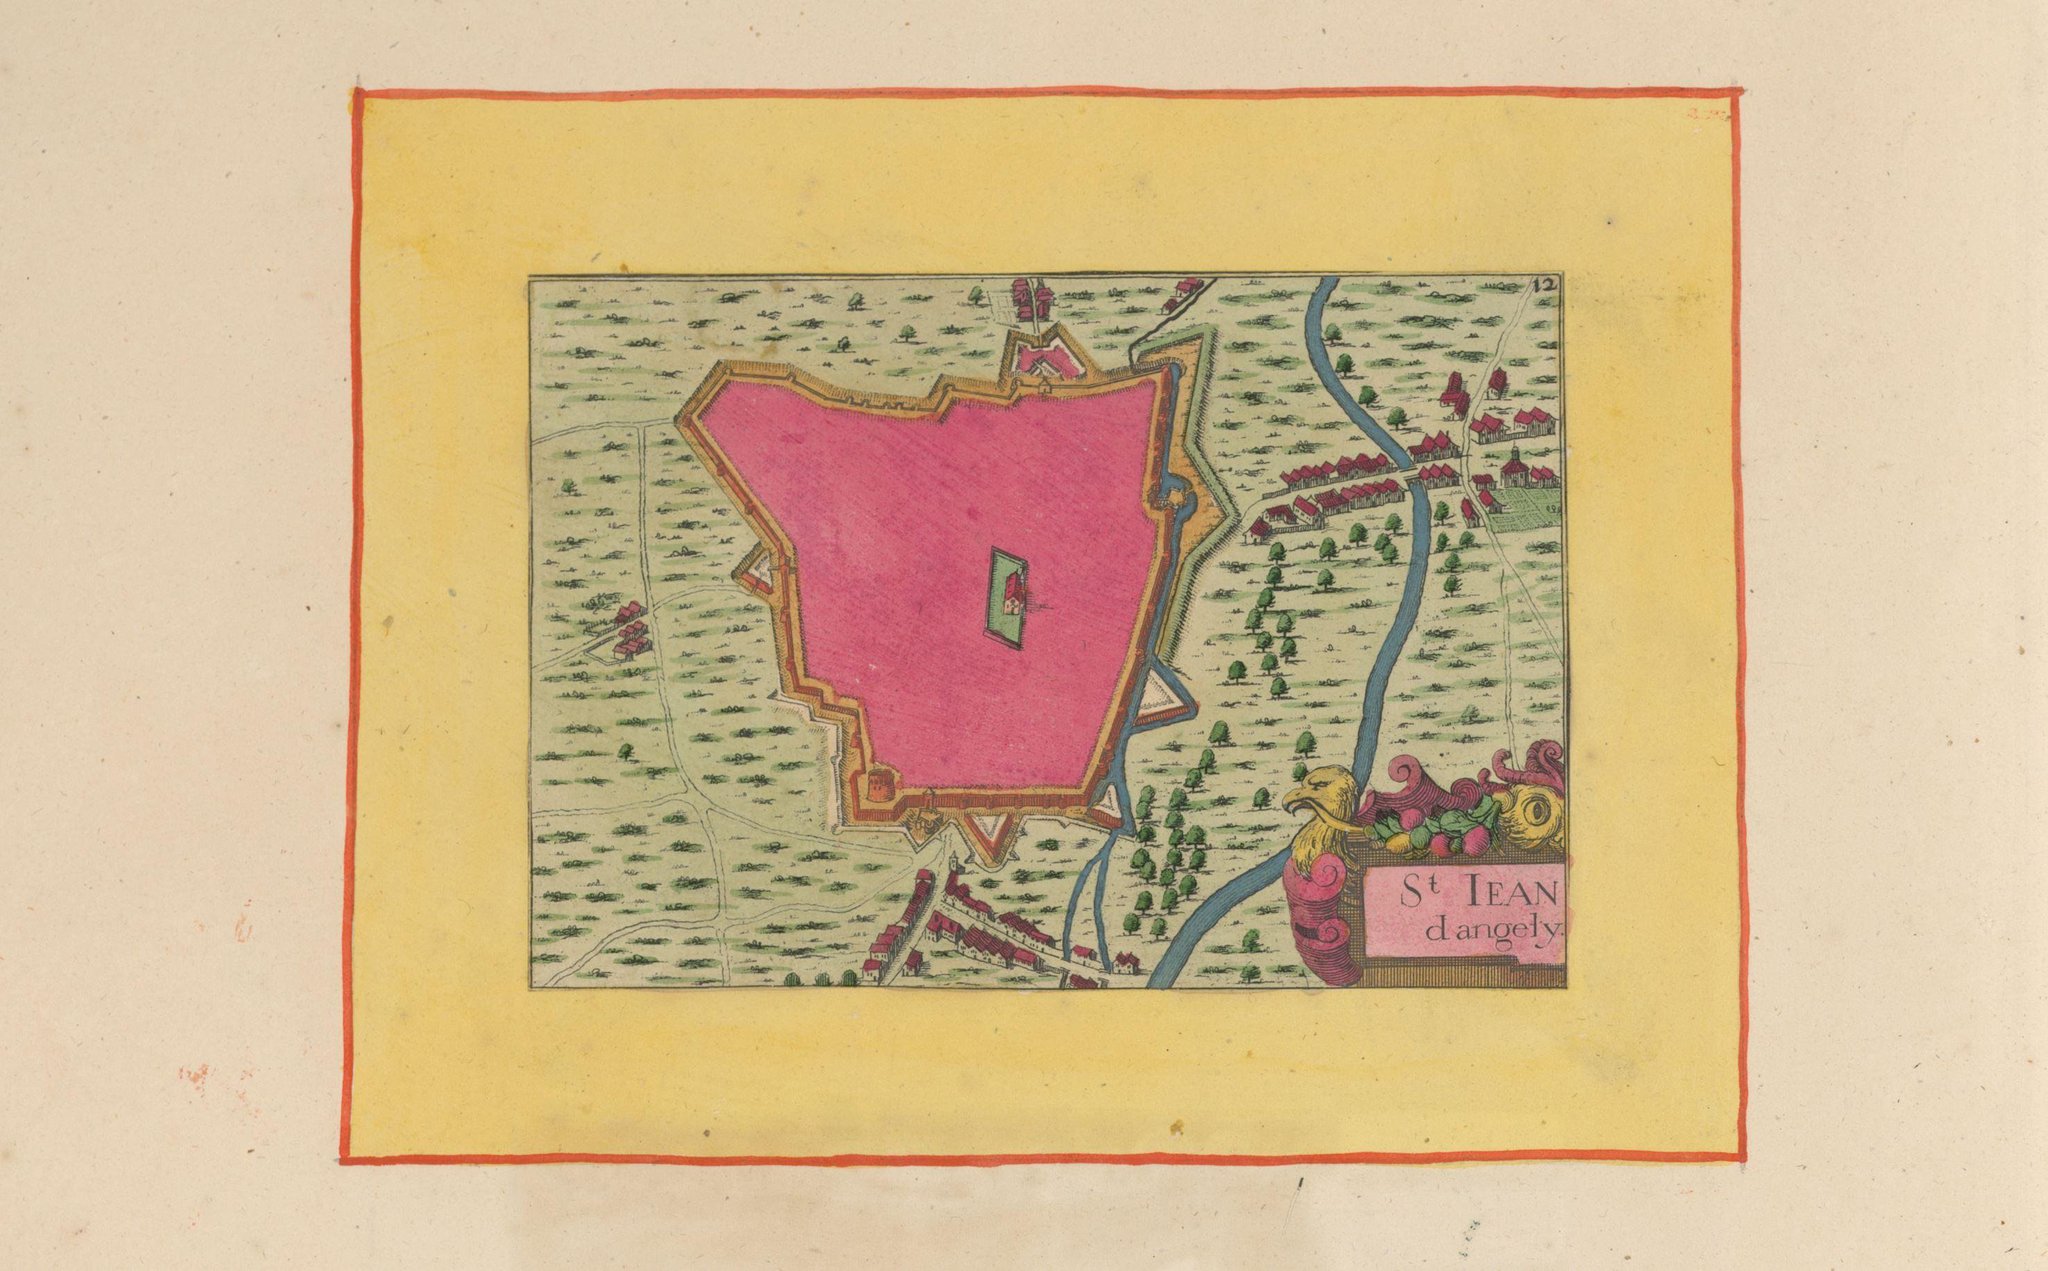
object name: album leaf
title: St. Jean d'Angely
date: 1638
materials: paper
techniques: engraving, etching, hand coloring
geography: the hague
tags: maps of cities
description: Prent uit: Tassin, Christophe. Les plans et profils de toutes les principales villes et lieux considérables de France (...). Parijs: Michel van Lochom, 1638, kaart 12 uit het deel 'Poictou'.